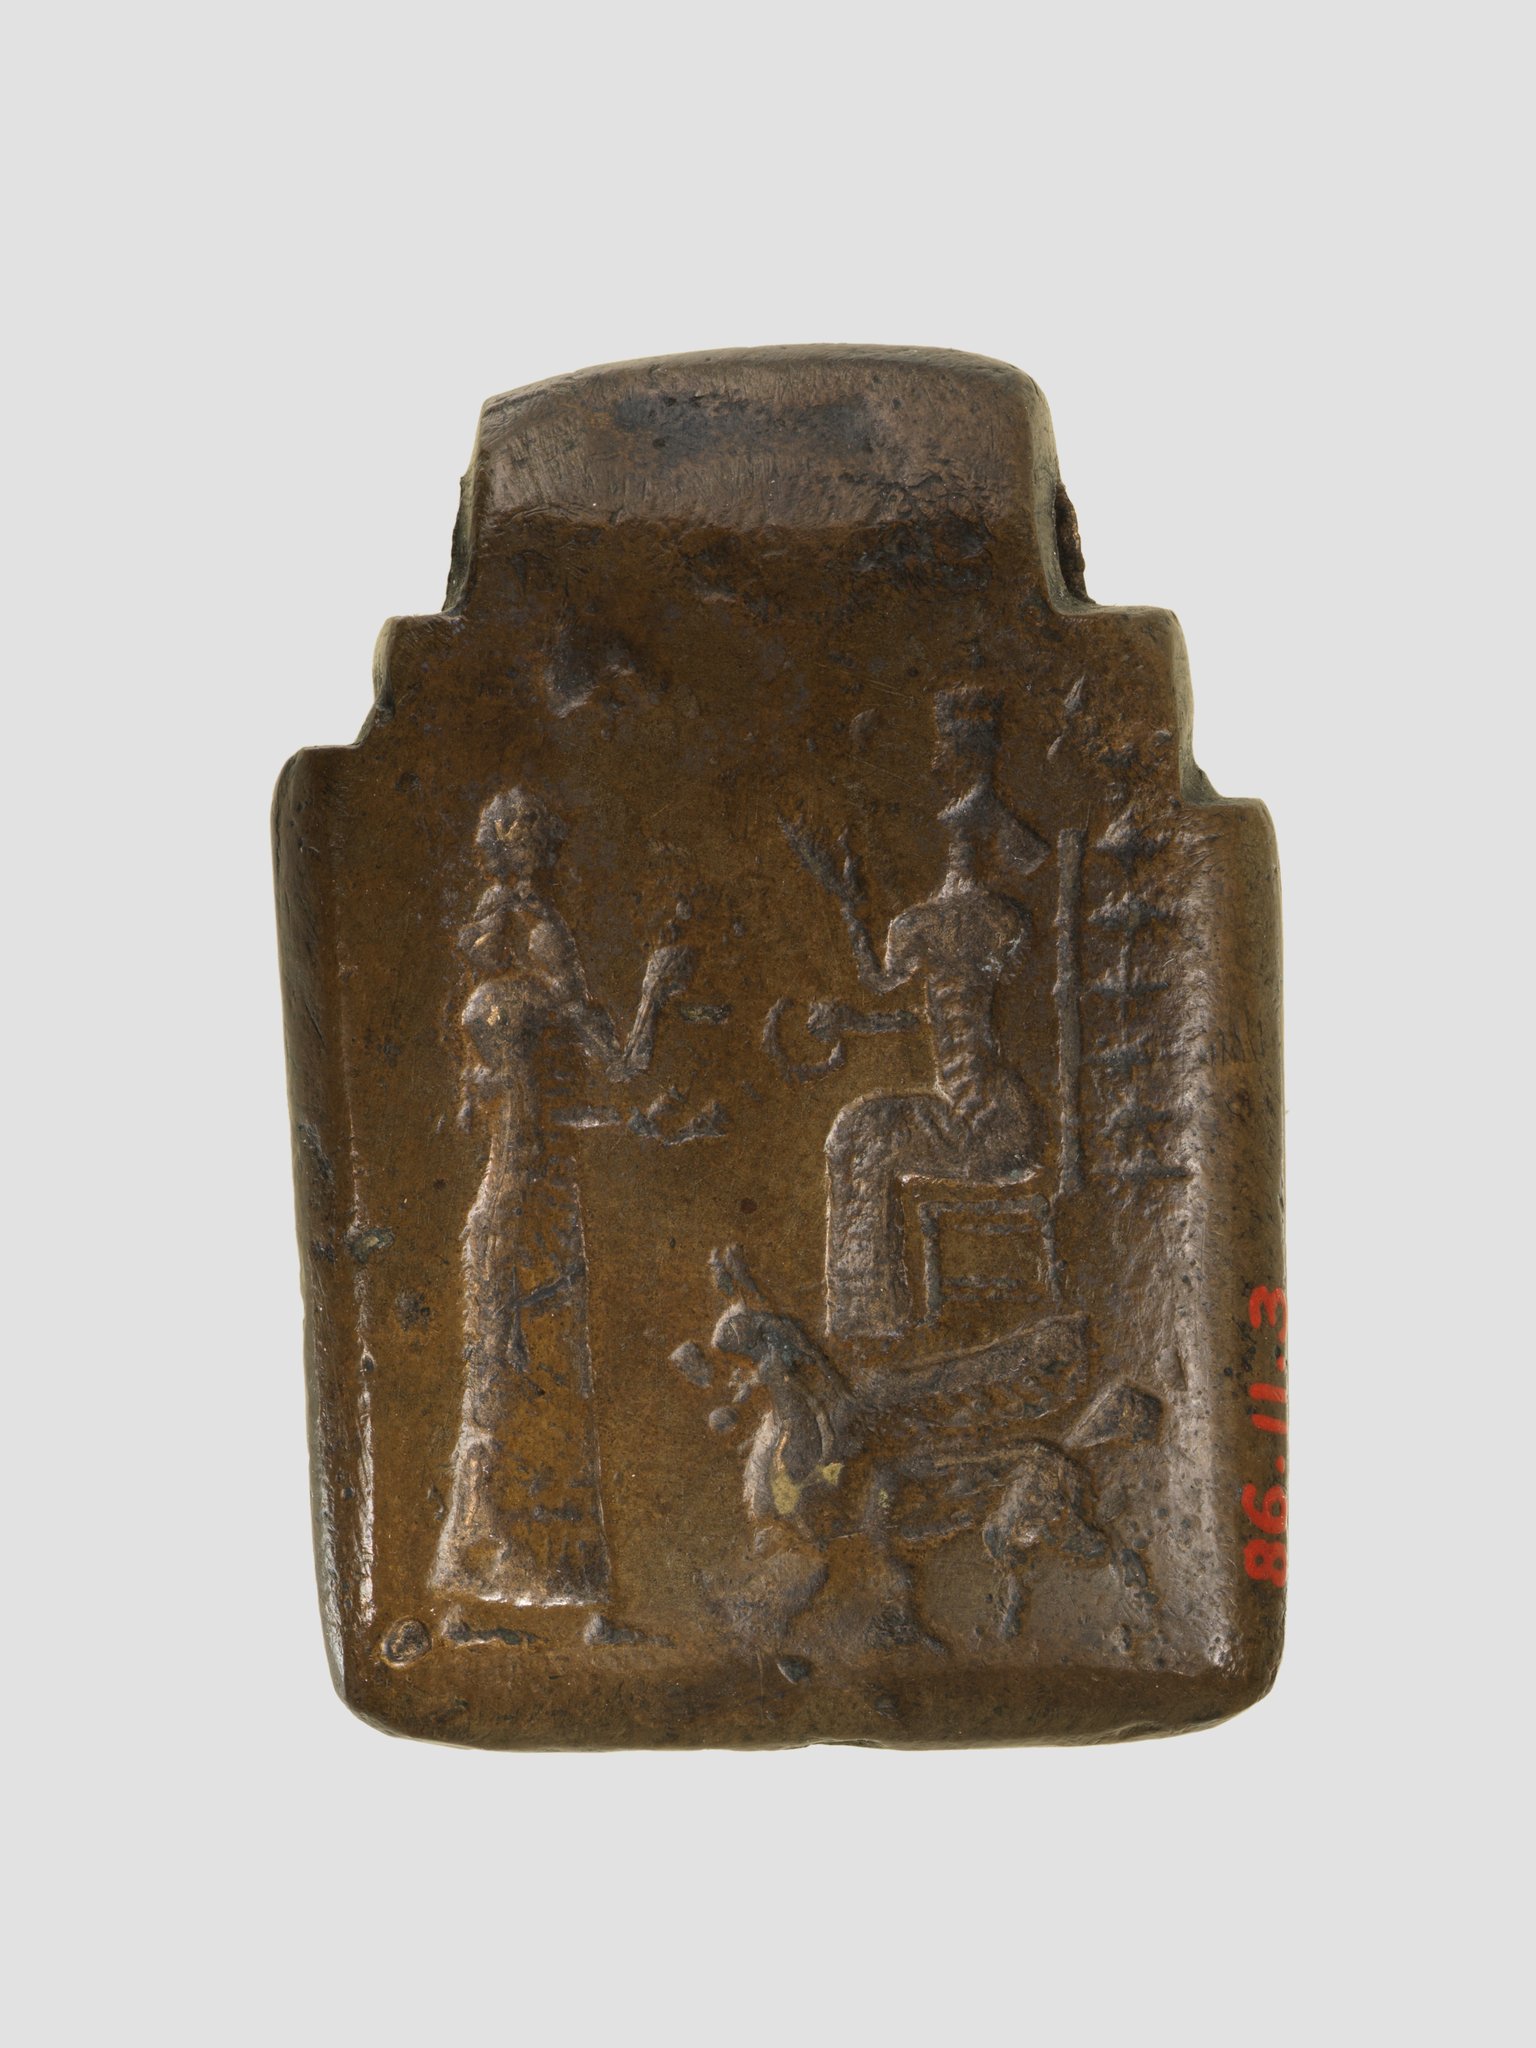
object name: necklace, bead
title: Amulet with fighting demons; on reverse: Ishtar enthroned and worshiper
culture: assyrian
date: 800-601 BCE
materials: bronze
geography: mesopotamia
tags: demons